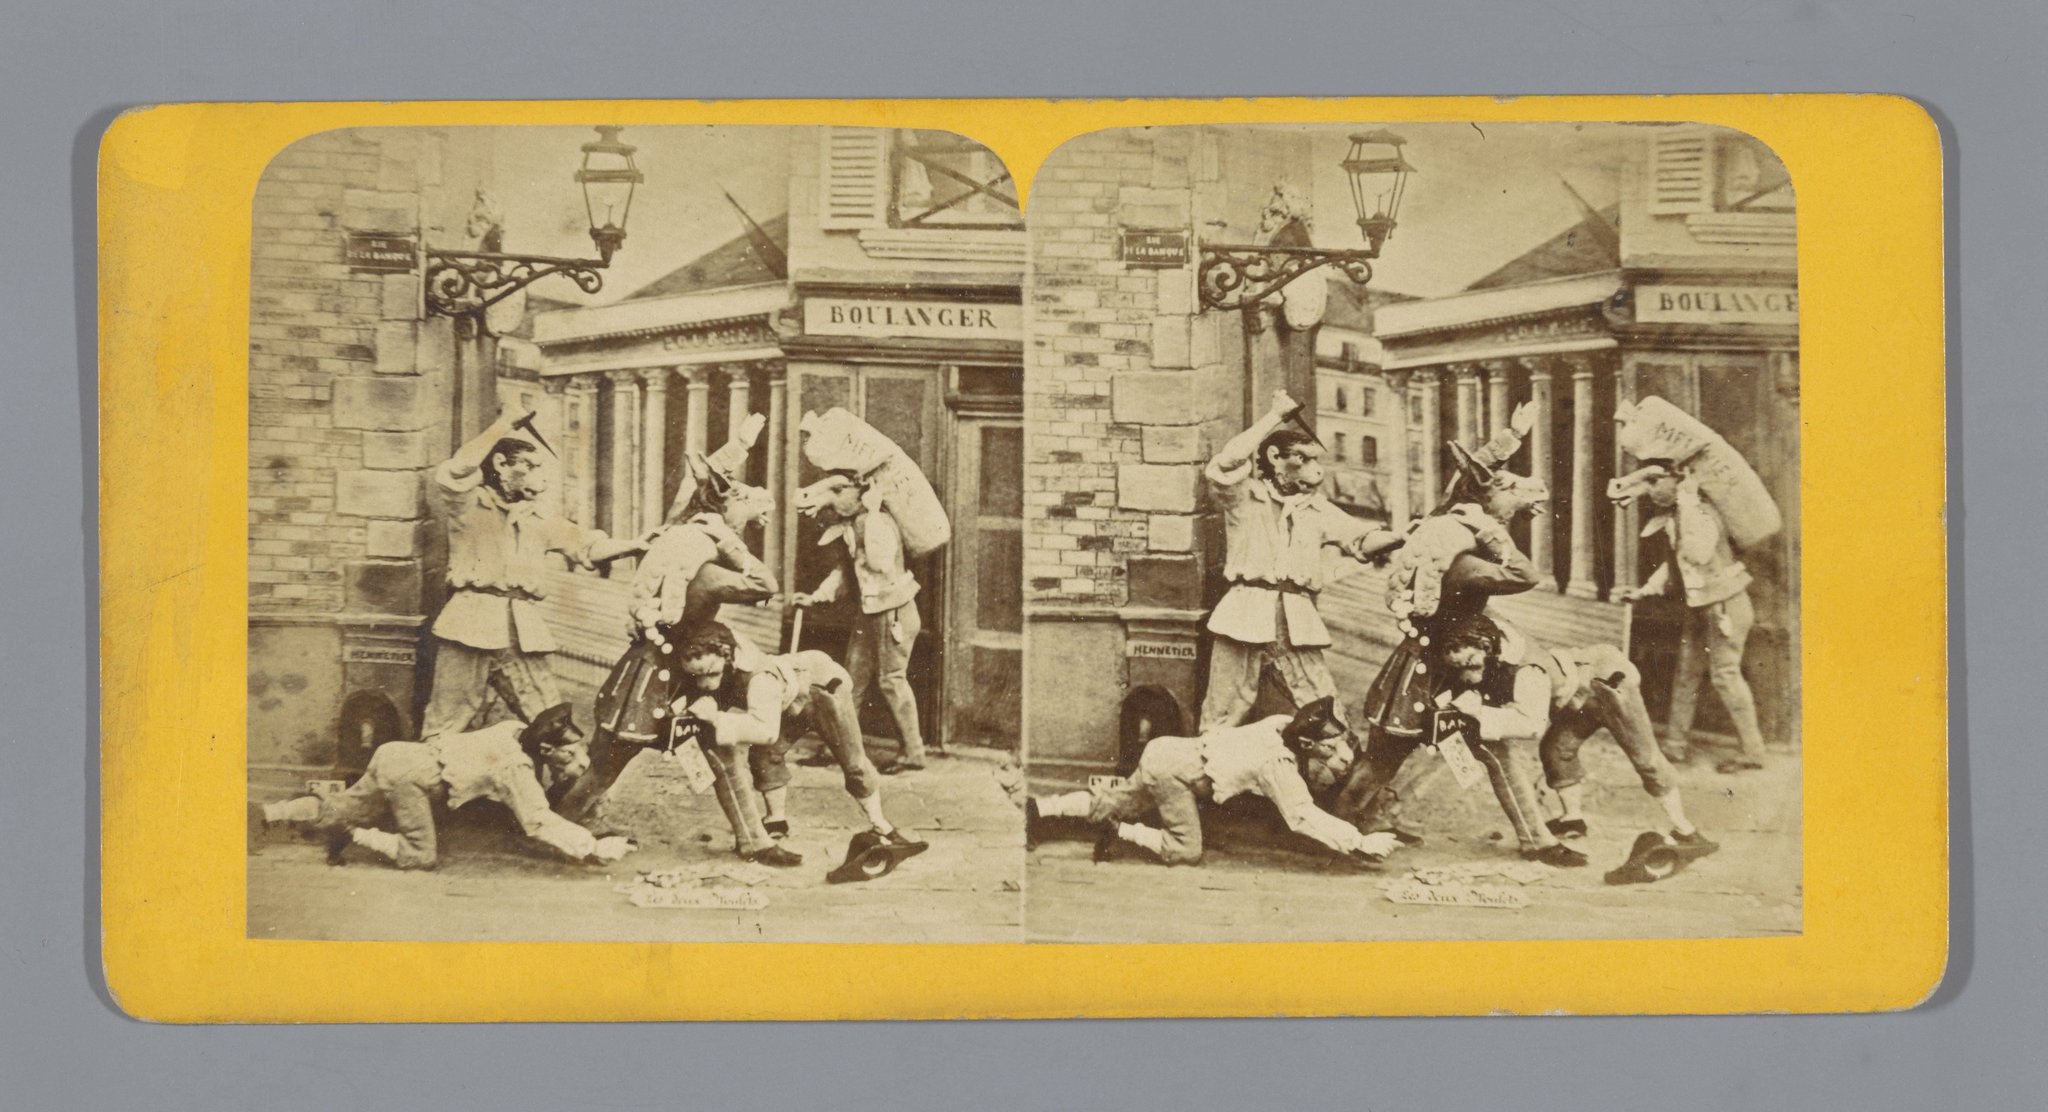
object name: stereograph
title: Enscenering met poppen, voorstellend een gevecht van figuren met dierenmaskers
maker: Anonymous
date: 1850-1880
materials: cardboard, photographic support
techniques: albumen print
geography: europe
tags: mask, (playing with) dolls, fighting, europe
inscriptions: inscription: ‘2,-’